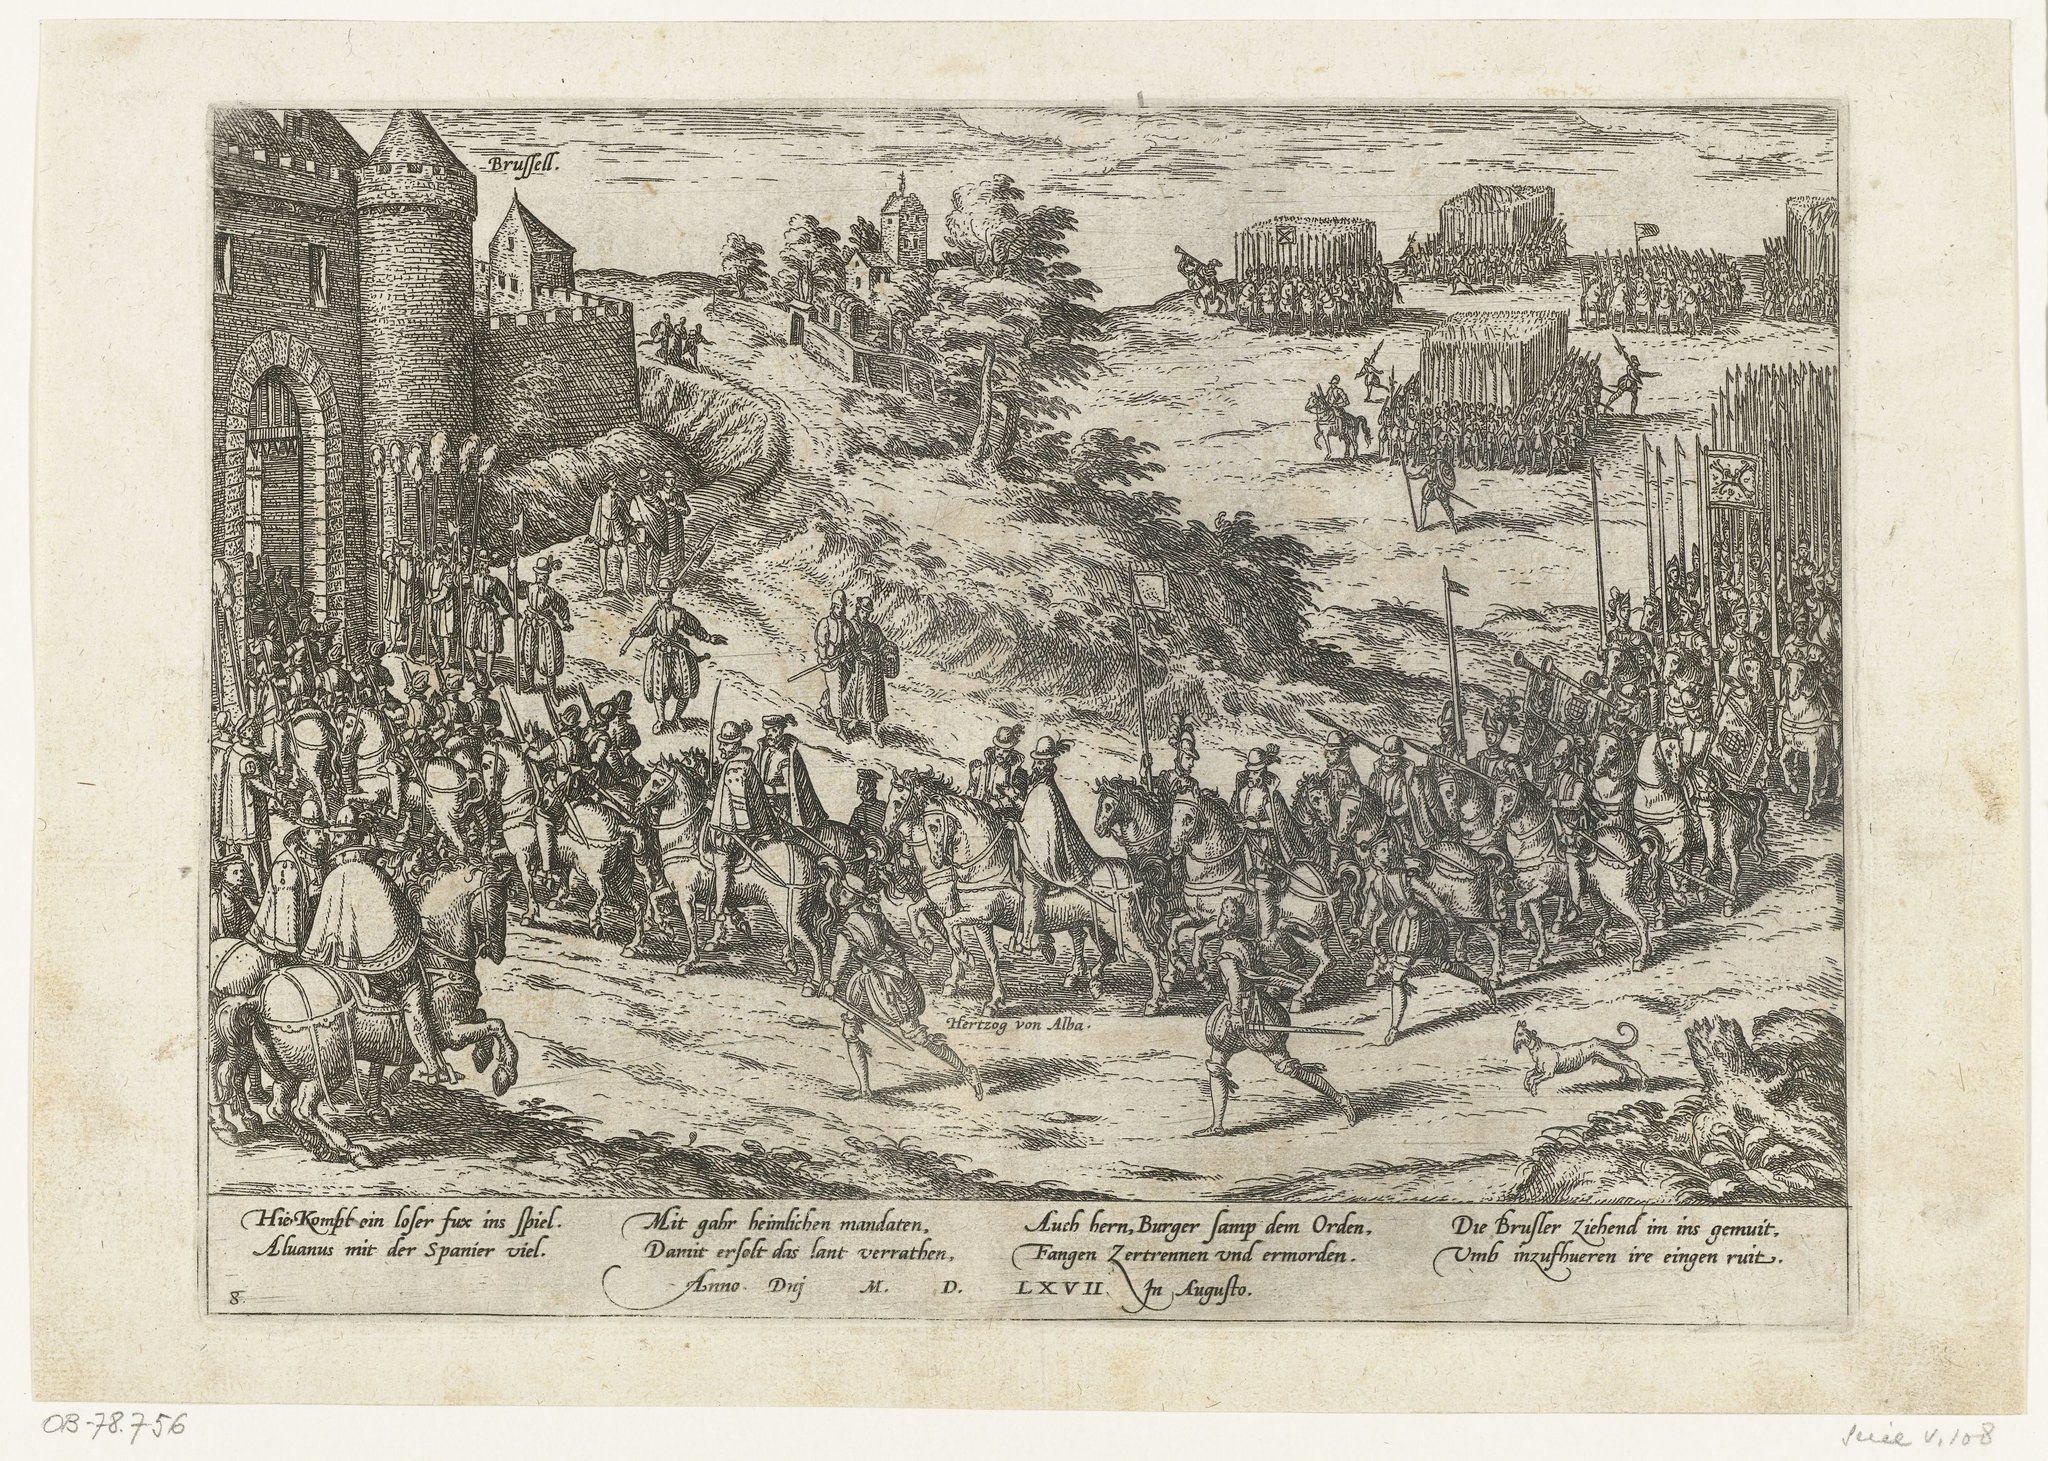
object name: print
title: Aankomst van de hertog van Alva te Brussel, 1567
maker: frans hogenberg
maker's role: print maker, publisher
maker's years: 1538-1590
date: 1567-1570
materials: paper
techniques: etching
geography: cologne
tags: fernando álvarez de toledo (3rd duke of alba), brussels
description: Aankomst van de hertog van Alva te Brussel, augustus 1567. Alva te paard arriveert met zijn leger bij de poort van de stad. Met onderschrift van 8 regels in het Duits. Genummerd: 8.